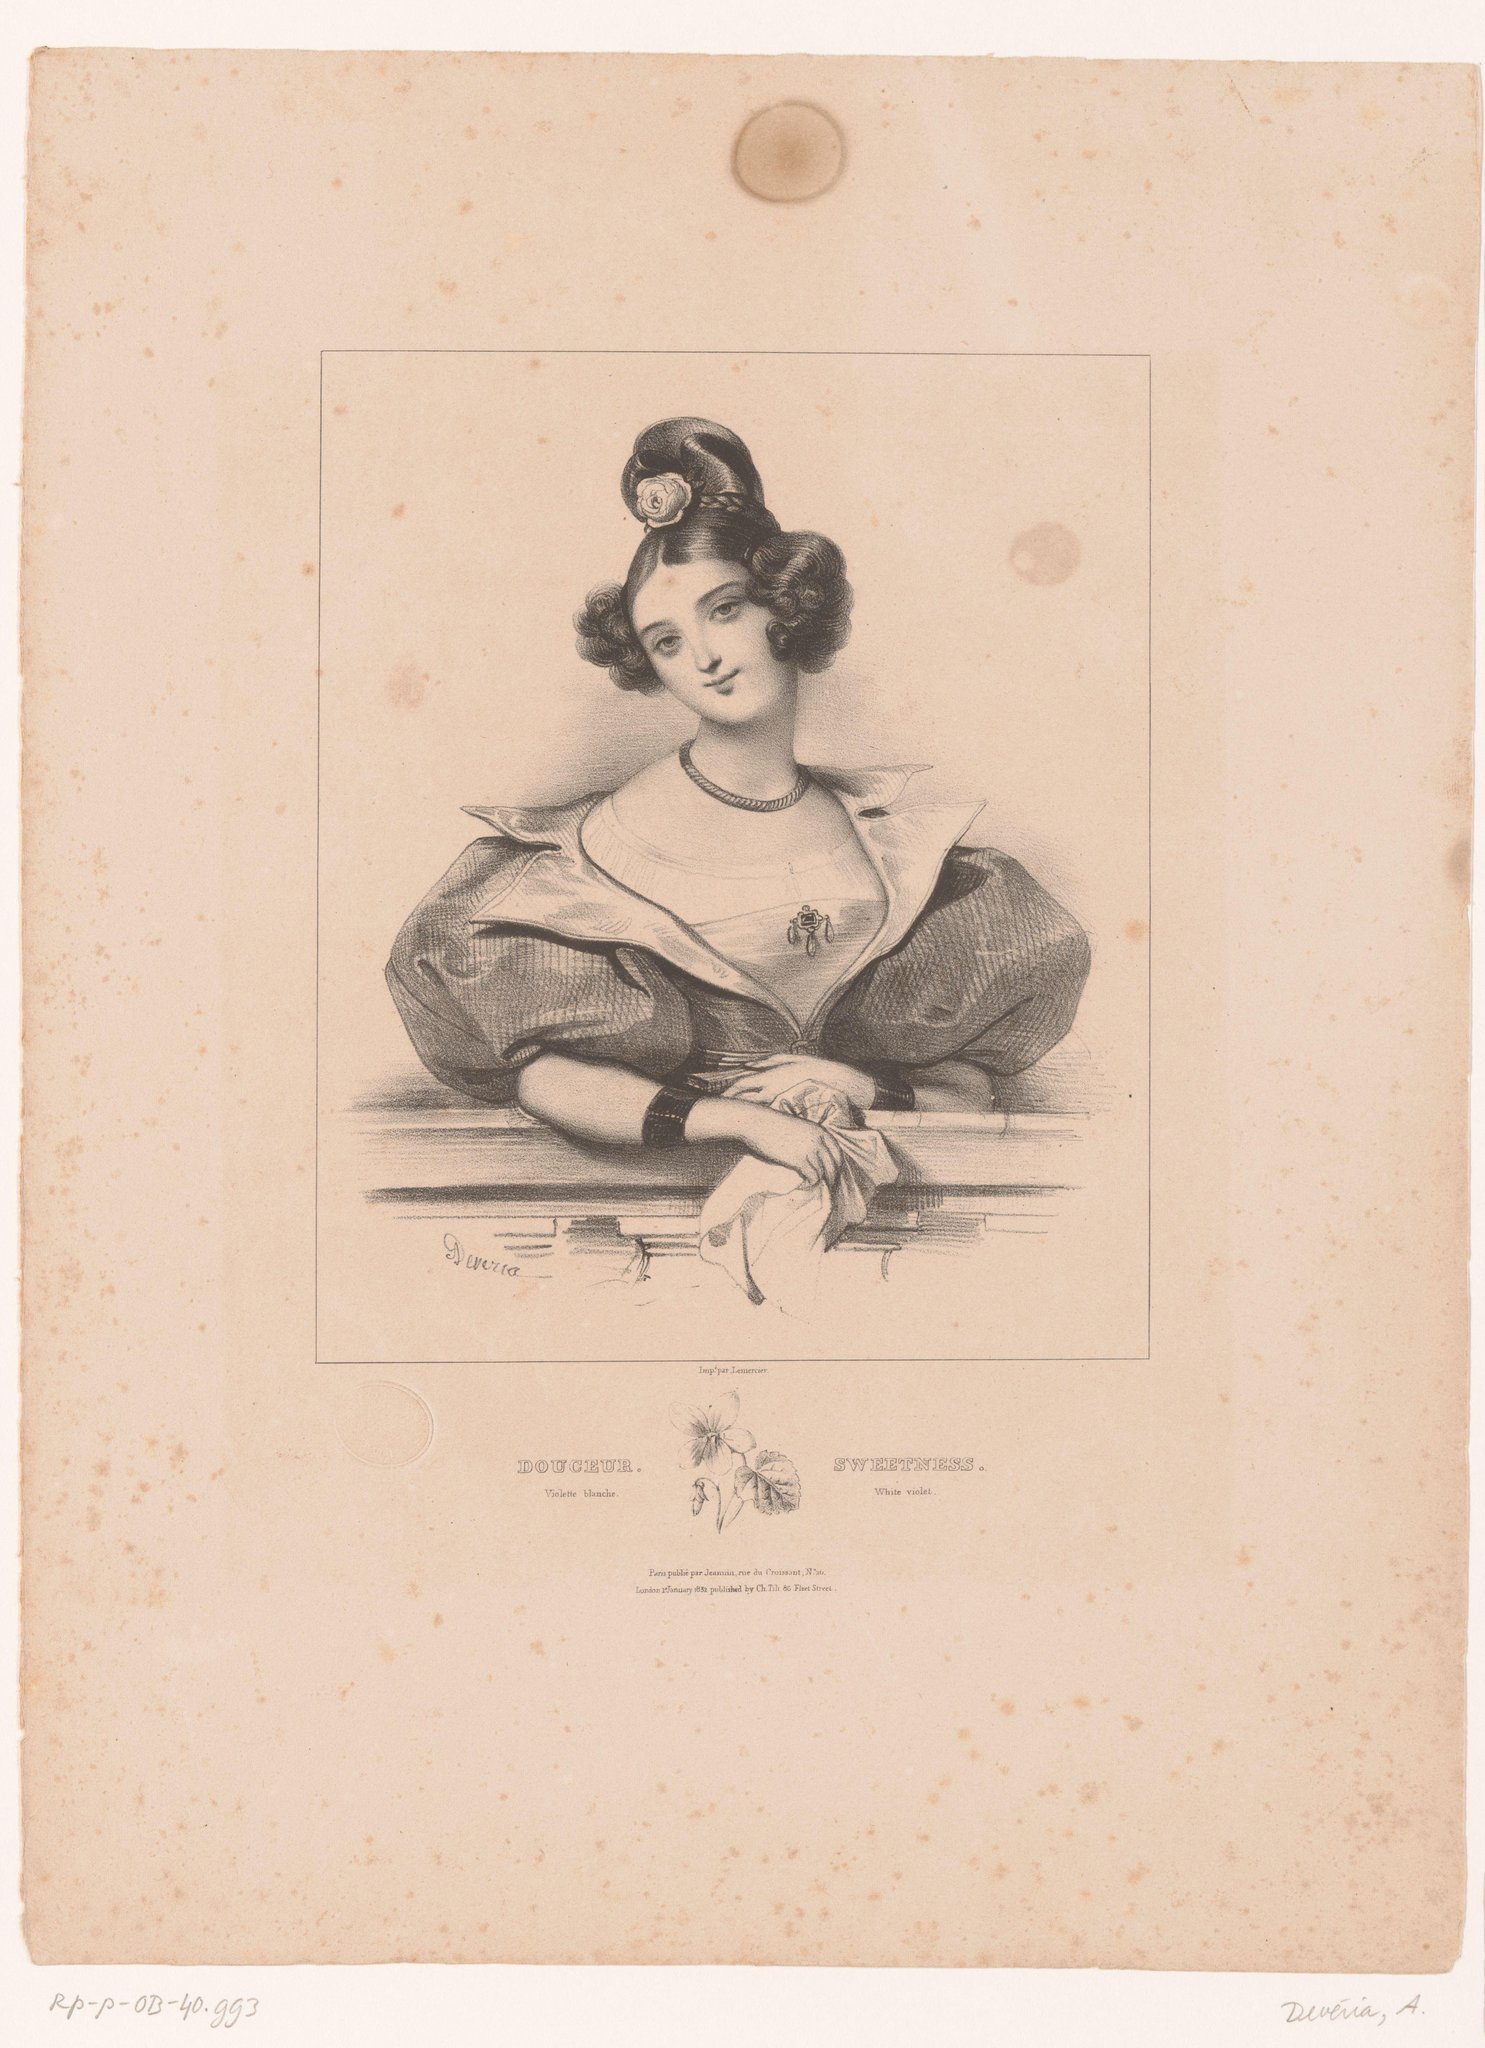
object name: print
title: Viola alba en lieftalligheid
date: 1831-1832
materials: paper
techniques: lithograph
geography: paris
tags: friendliness, gentleness, affability; 'affabilità, piacevolezza, amabilità', 'animo piacevole, trattabile & amorevole', 'benignità' (ripa), adolescent, young woman, maiden, flowers: violet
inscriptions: check stamp: Lugt 3987